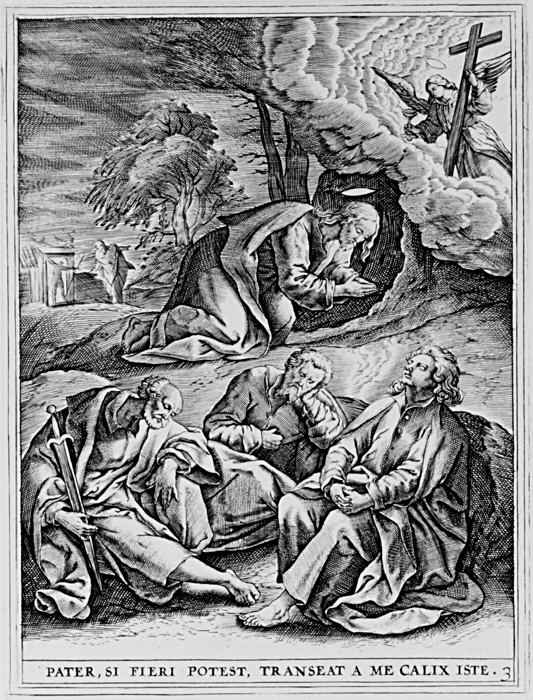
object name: print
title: Christ Praying in the Garden on the Mount of Olives, from "The Passion of Christ (Passio Domni Nostri Jesu Christi)"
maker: hieronymus wierix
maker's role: artist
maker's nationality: netherlandish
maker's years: 1553-1619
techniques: engraving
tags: men,angels,christ,cross